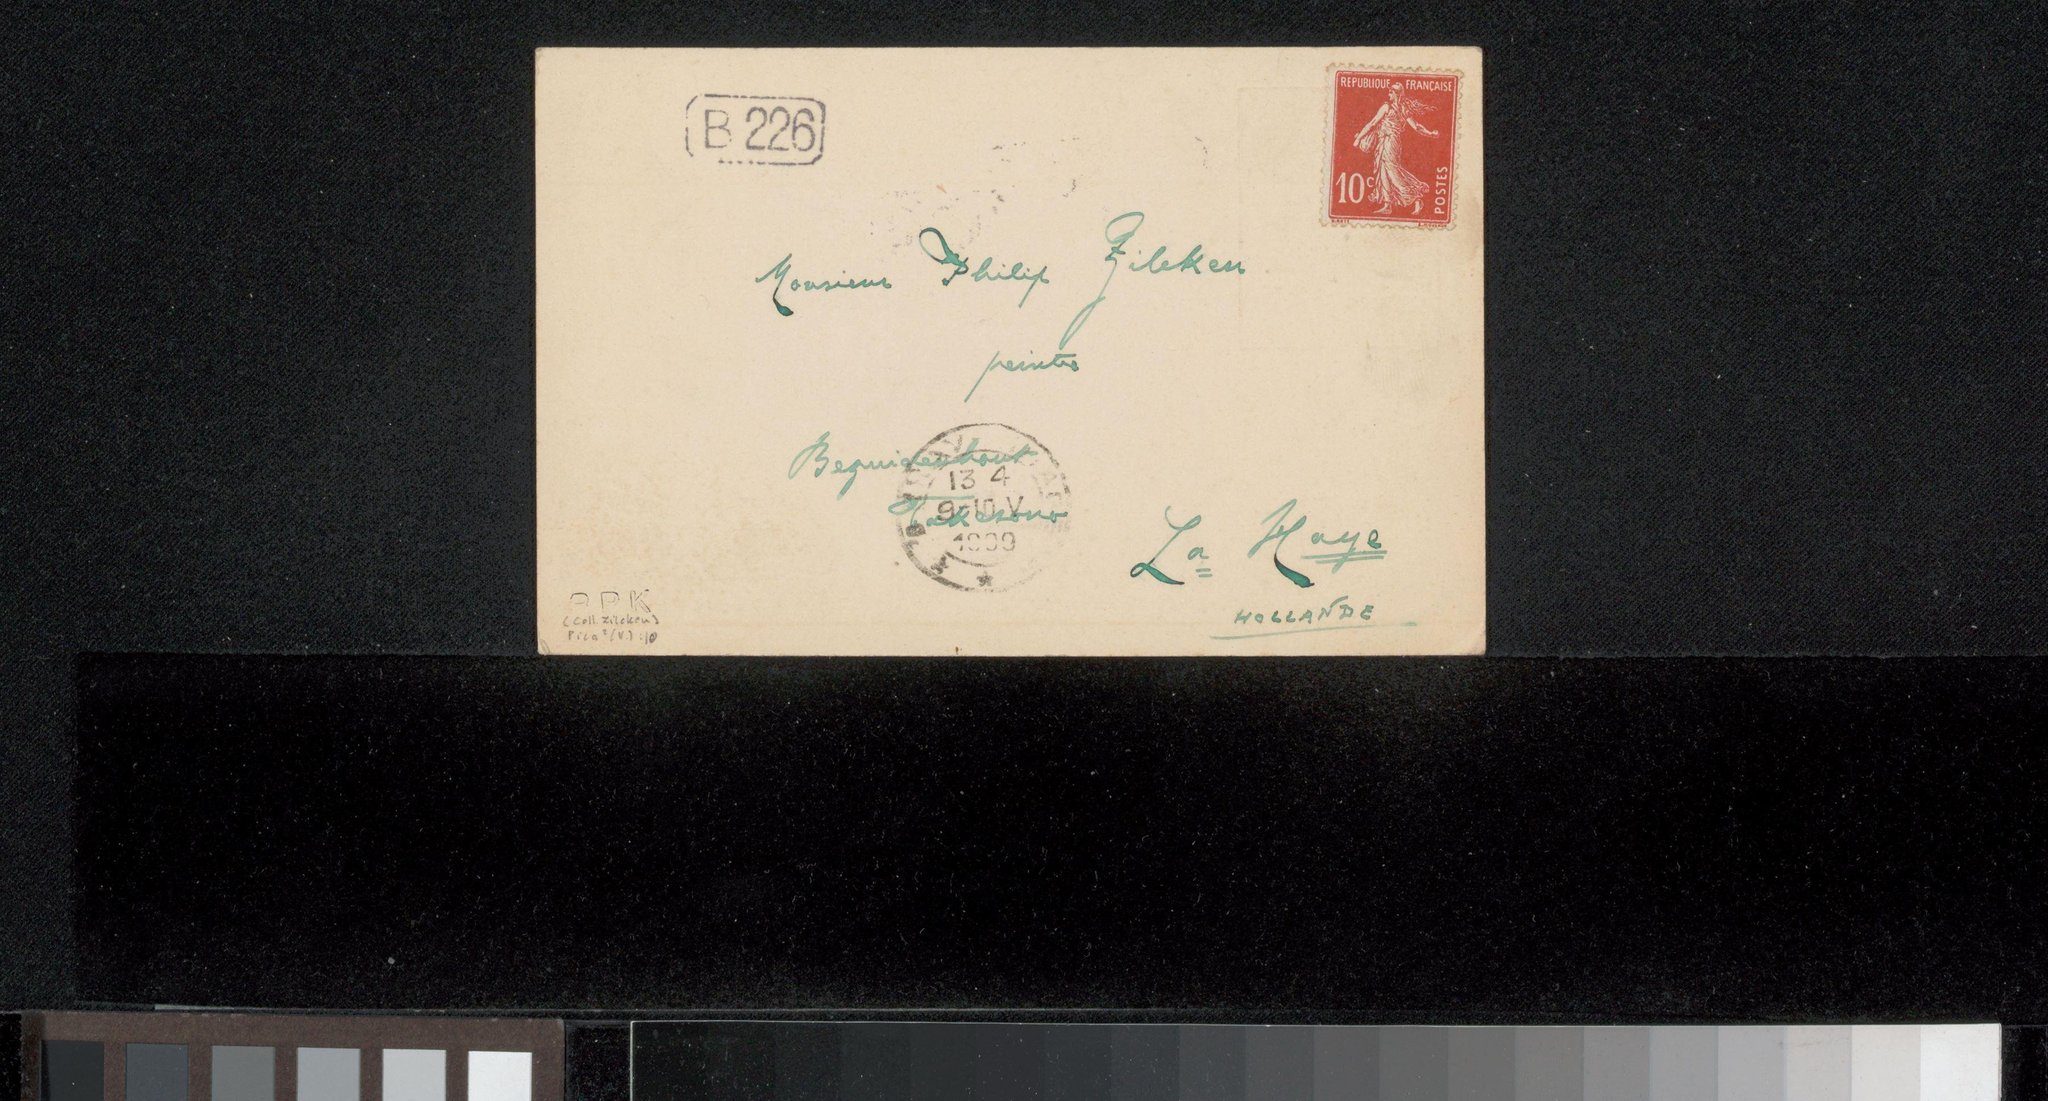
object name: letter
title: Brief aan Philip Zilcken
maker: vittorio pica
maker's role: criticus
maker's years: 1864-1930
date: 1909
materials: cardboard, ink, pencil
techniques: pen, printing, writing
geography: paris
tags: the hague, painter, draughtsman, philip zilcken, brussels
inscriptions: collector's mark: ‘RPK’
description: Brief bevat aantekening van Philip Zilcken.